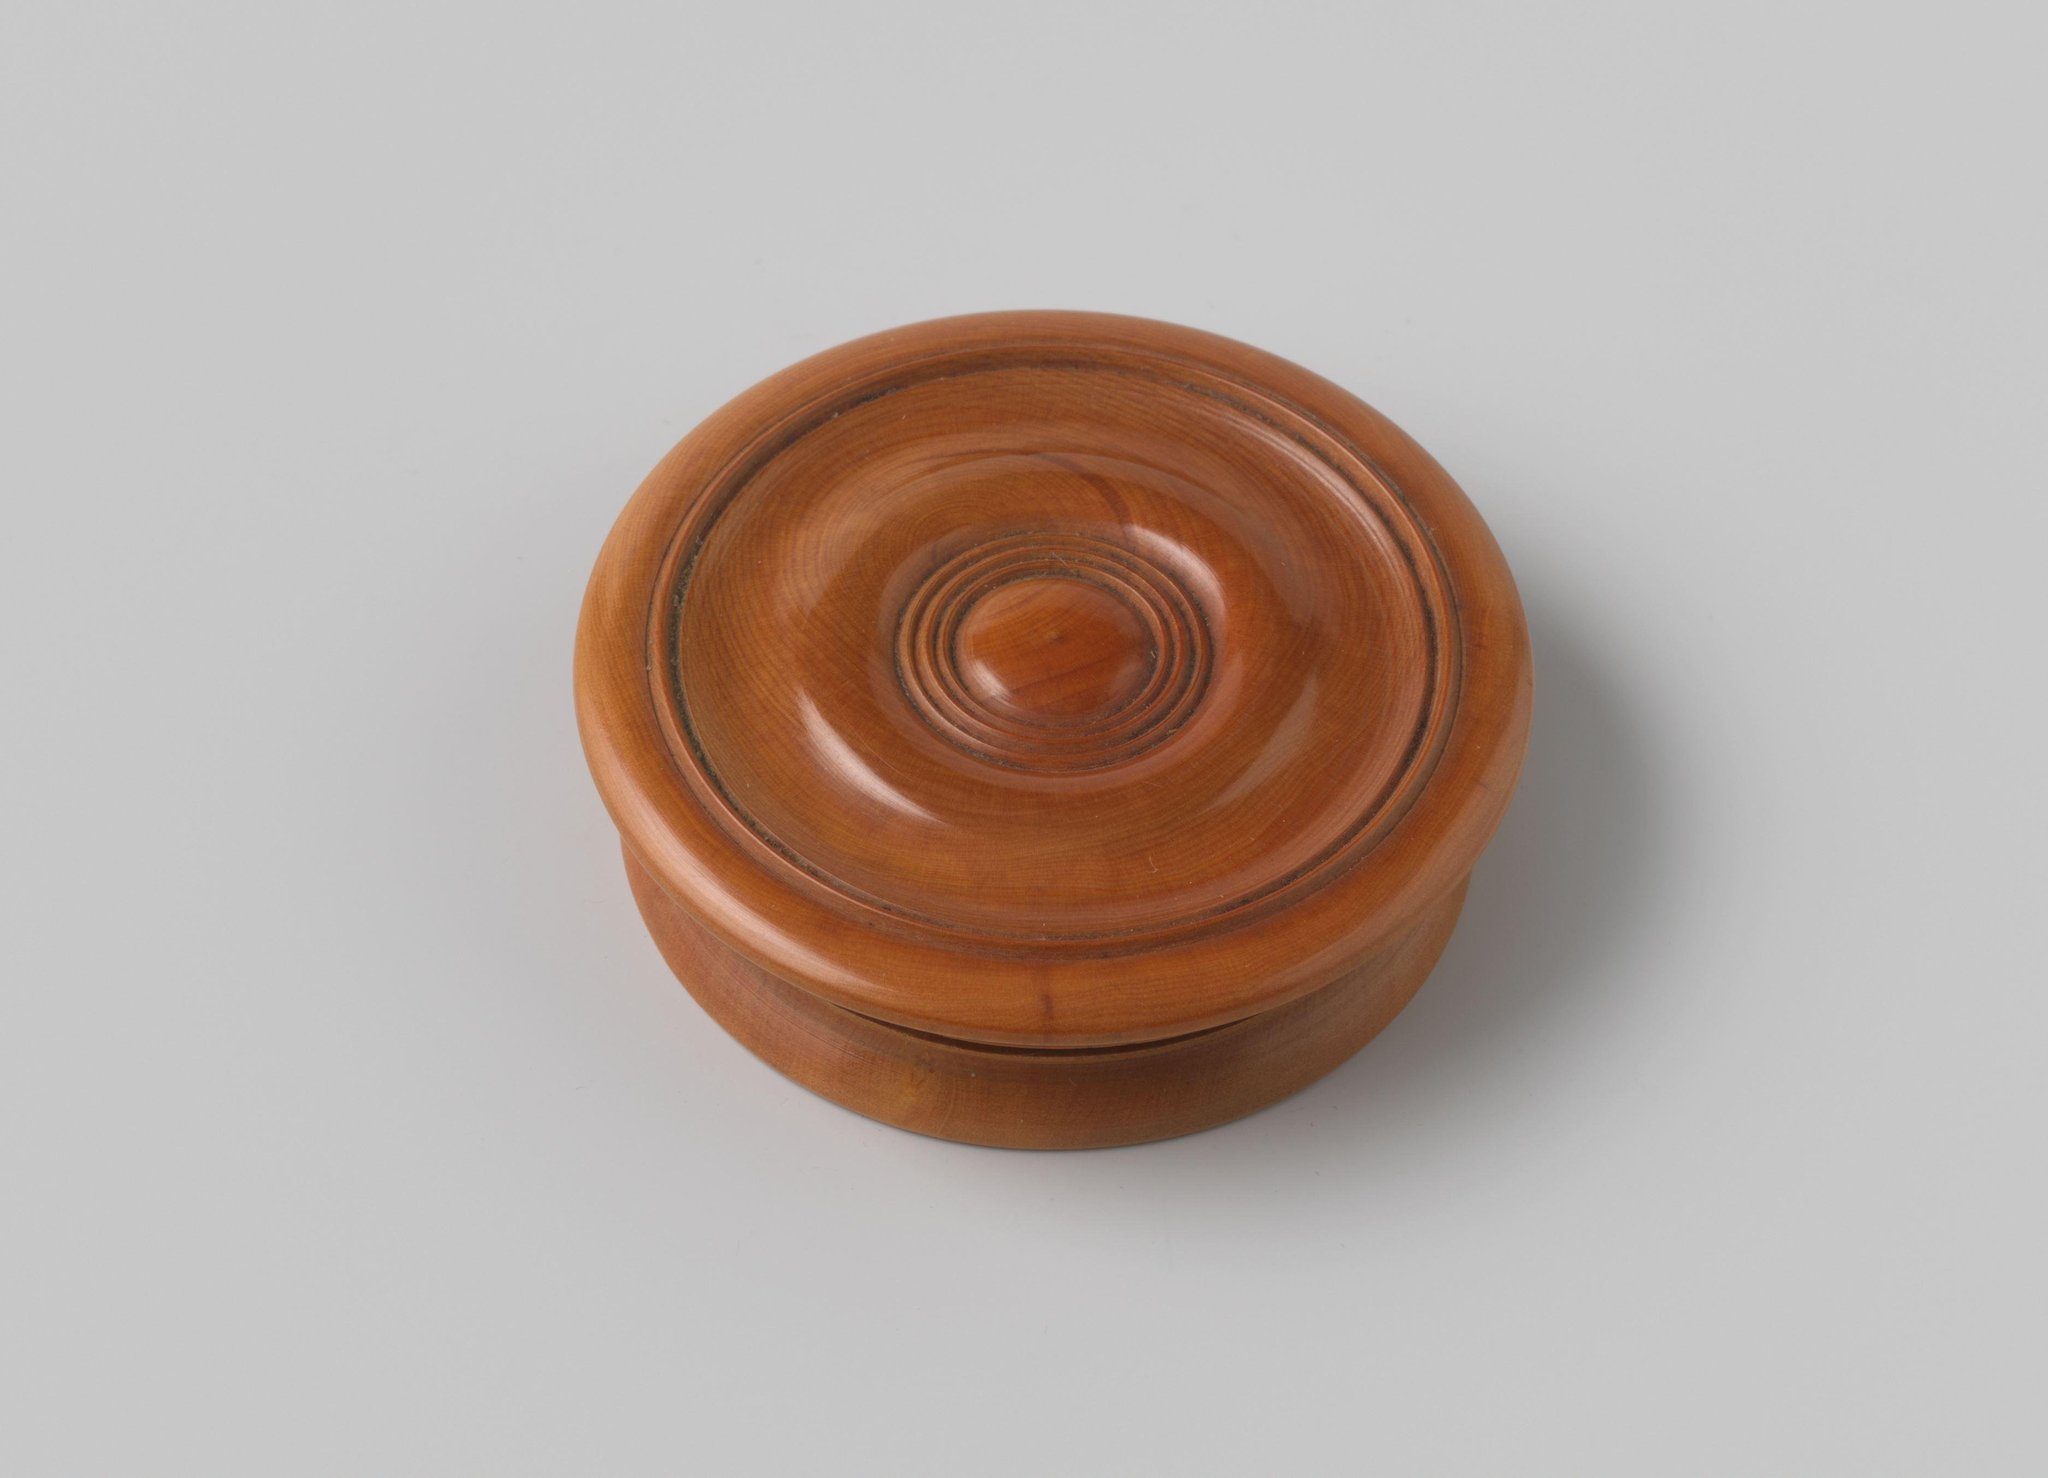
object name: medal box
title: Penningdoos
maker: Anonymous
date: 1846-1858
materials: wood, velvet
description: Perenhouten doosje, met binnenkant van rood fluweel. Bijbehorende penning BK-15215-1.